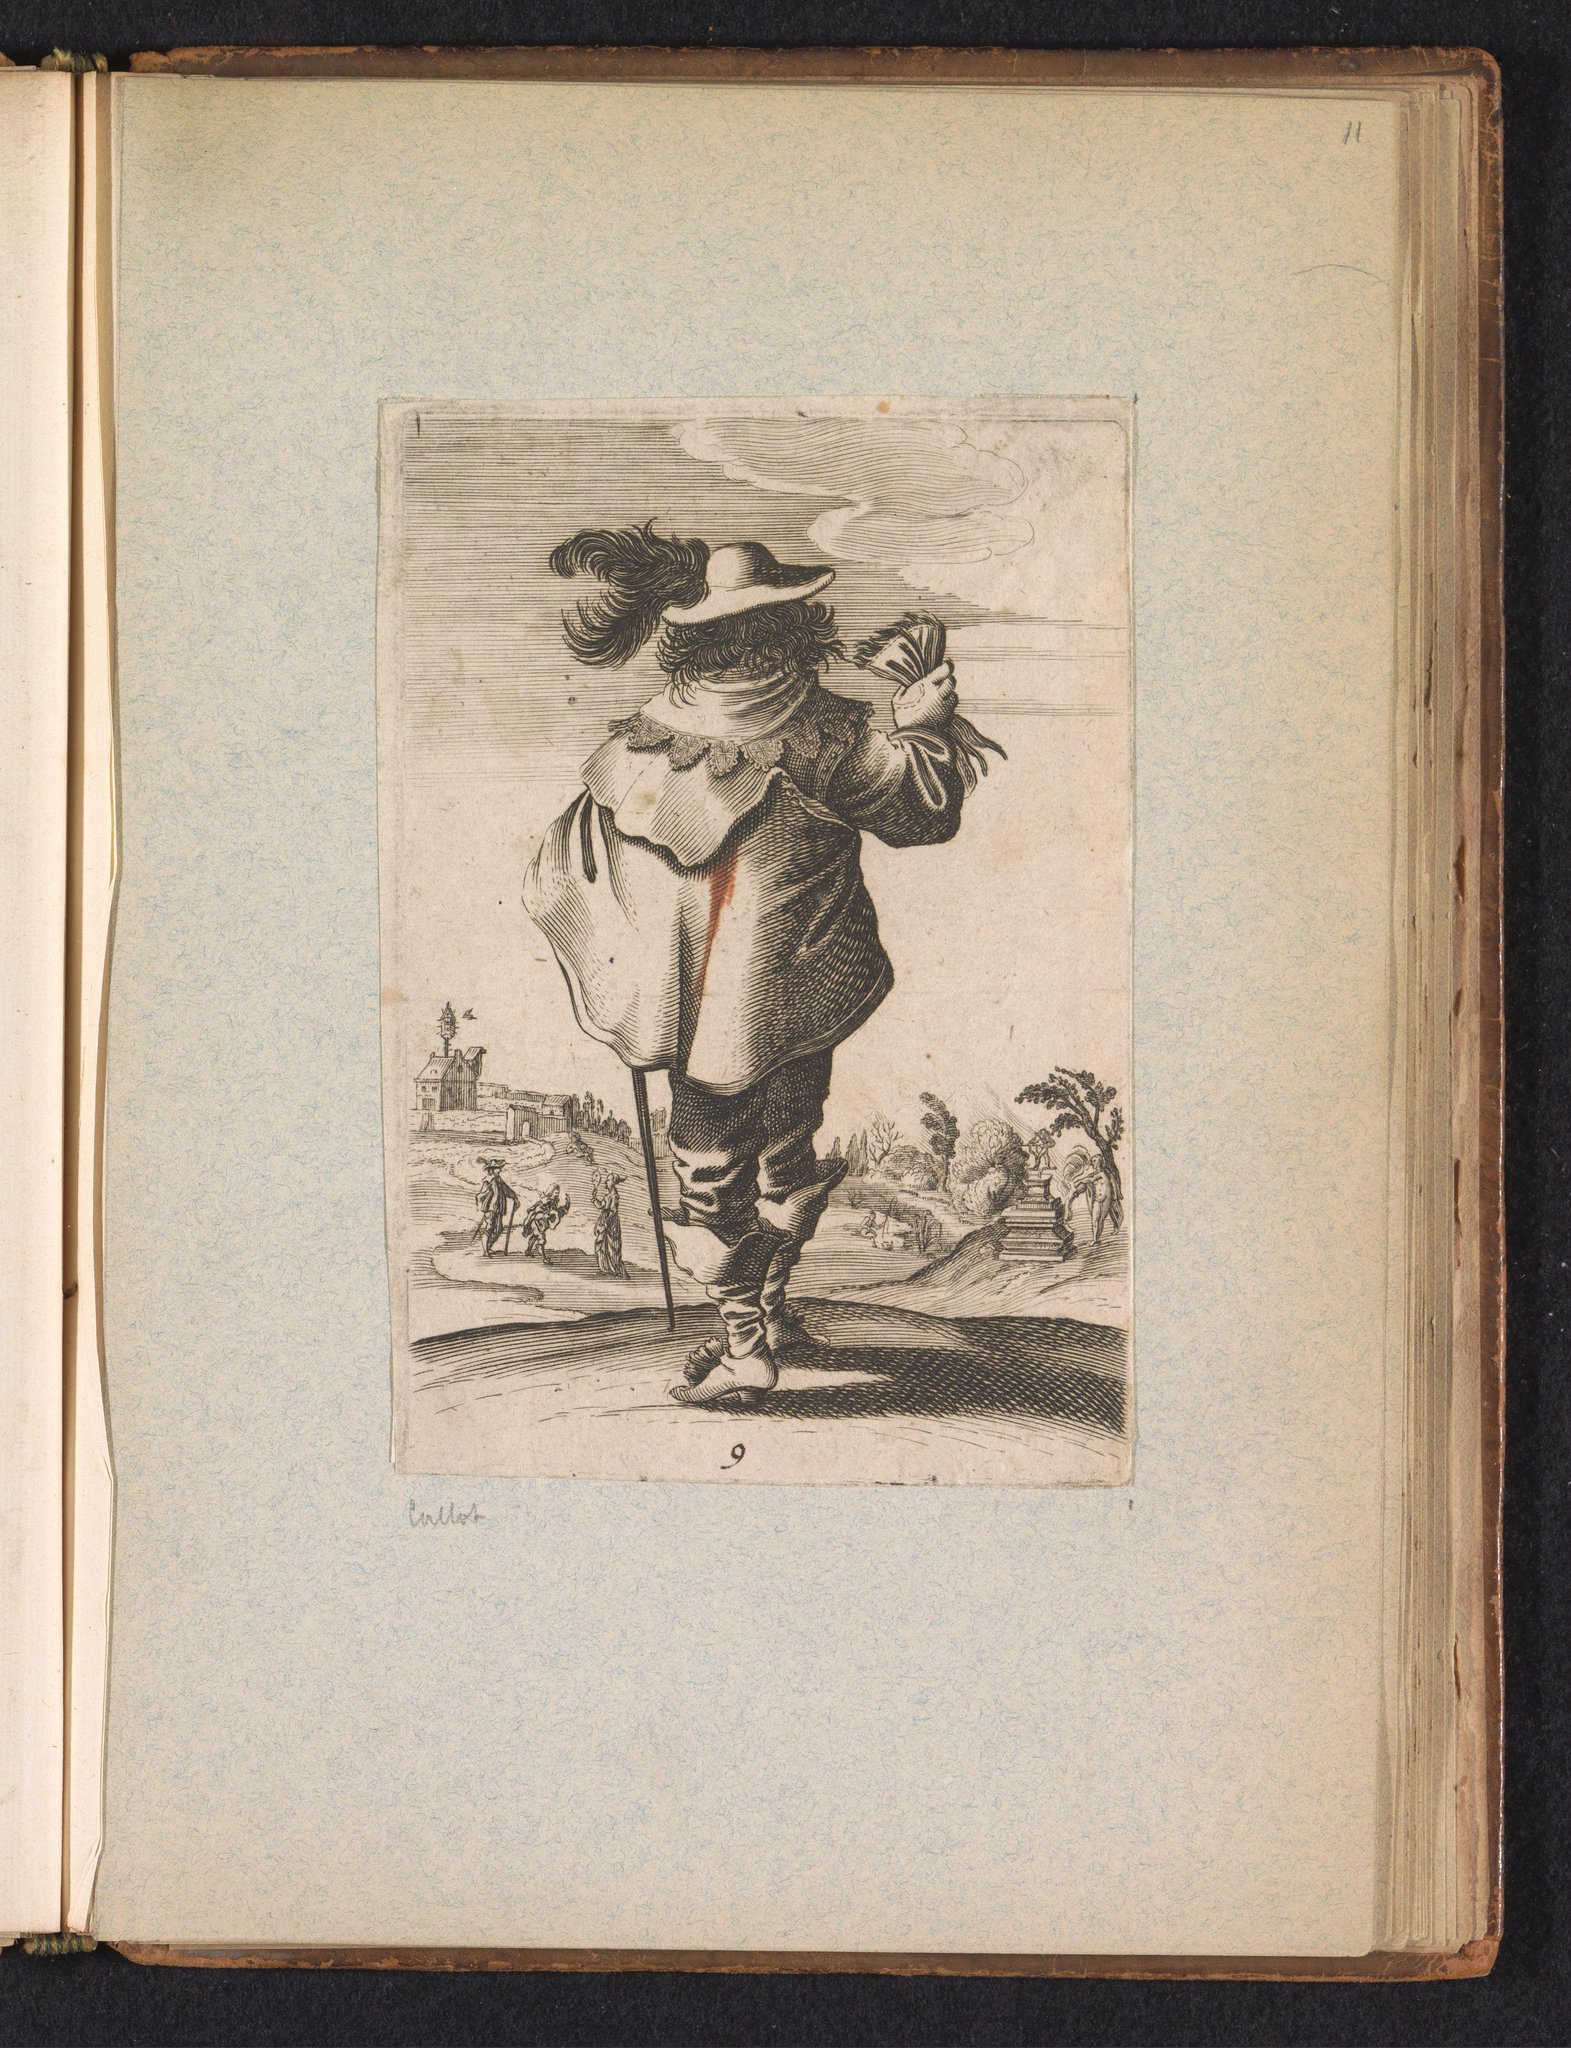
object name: costume print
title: Man, gekleed volgens de mode van omstreeks 1630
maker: Anonymous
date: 1630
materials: paper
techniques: etching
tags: cape (+ men's clothes), head-gear: hat (+ men's clothes), clothes, costume (+ men's clothes), trousers, breeches, etc. (breeches) (+ men's clothes), boots (+ men's clothes), gloves, mittens, etc. (+ men's clothes), head-gear: hat (+ feathers used for clothes)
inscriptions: number: ‘9’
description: Man, staand in landschap, van achteren gezien, gekleed volgens de Franse mode omstreeks 1620. Hoed met pluimen op het hoofd, handschoenen in zijn rechterhand.